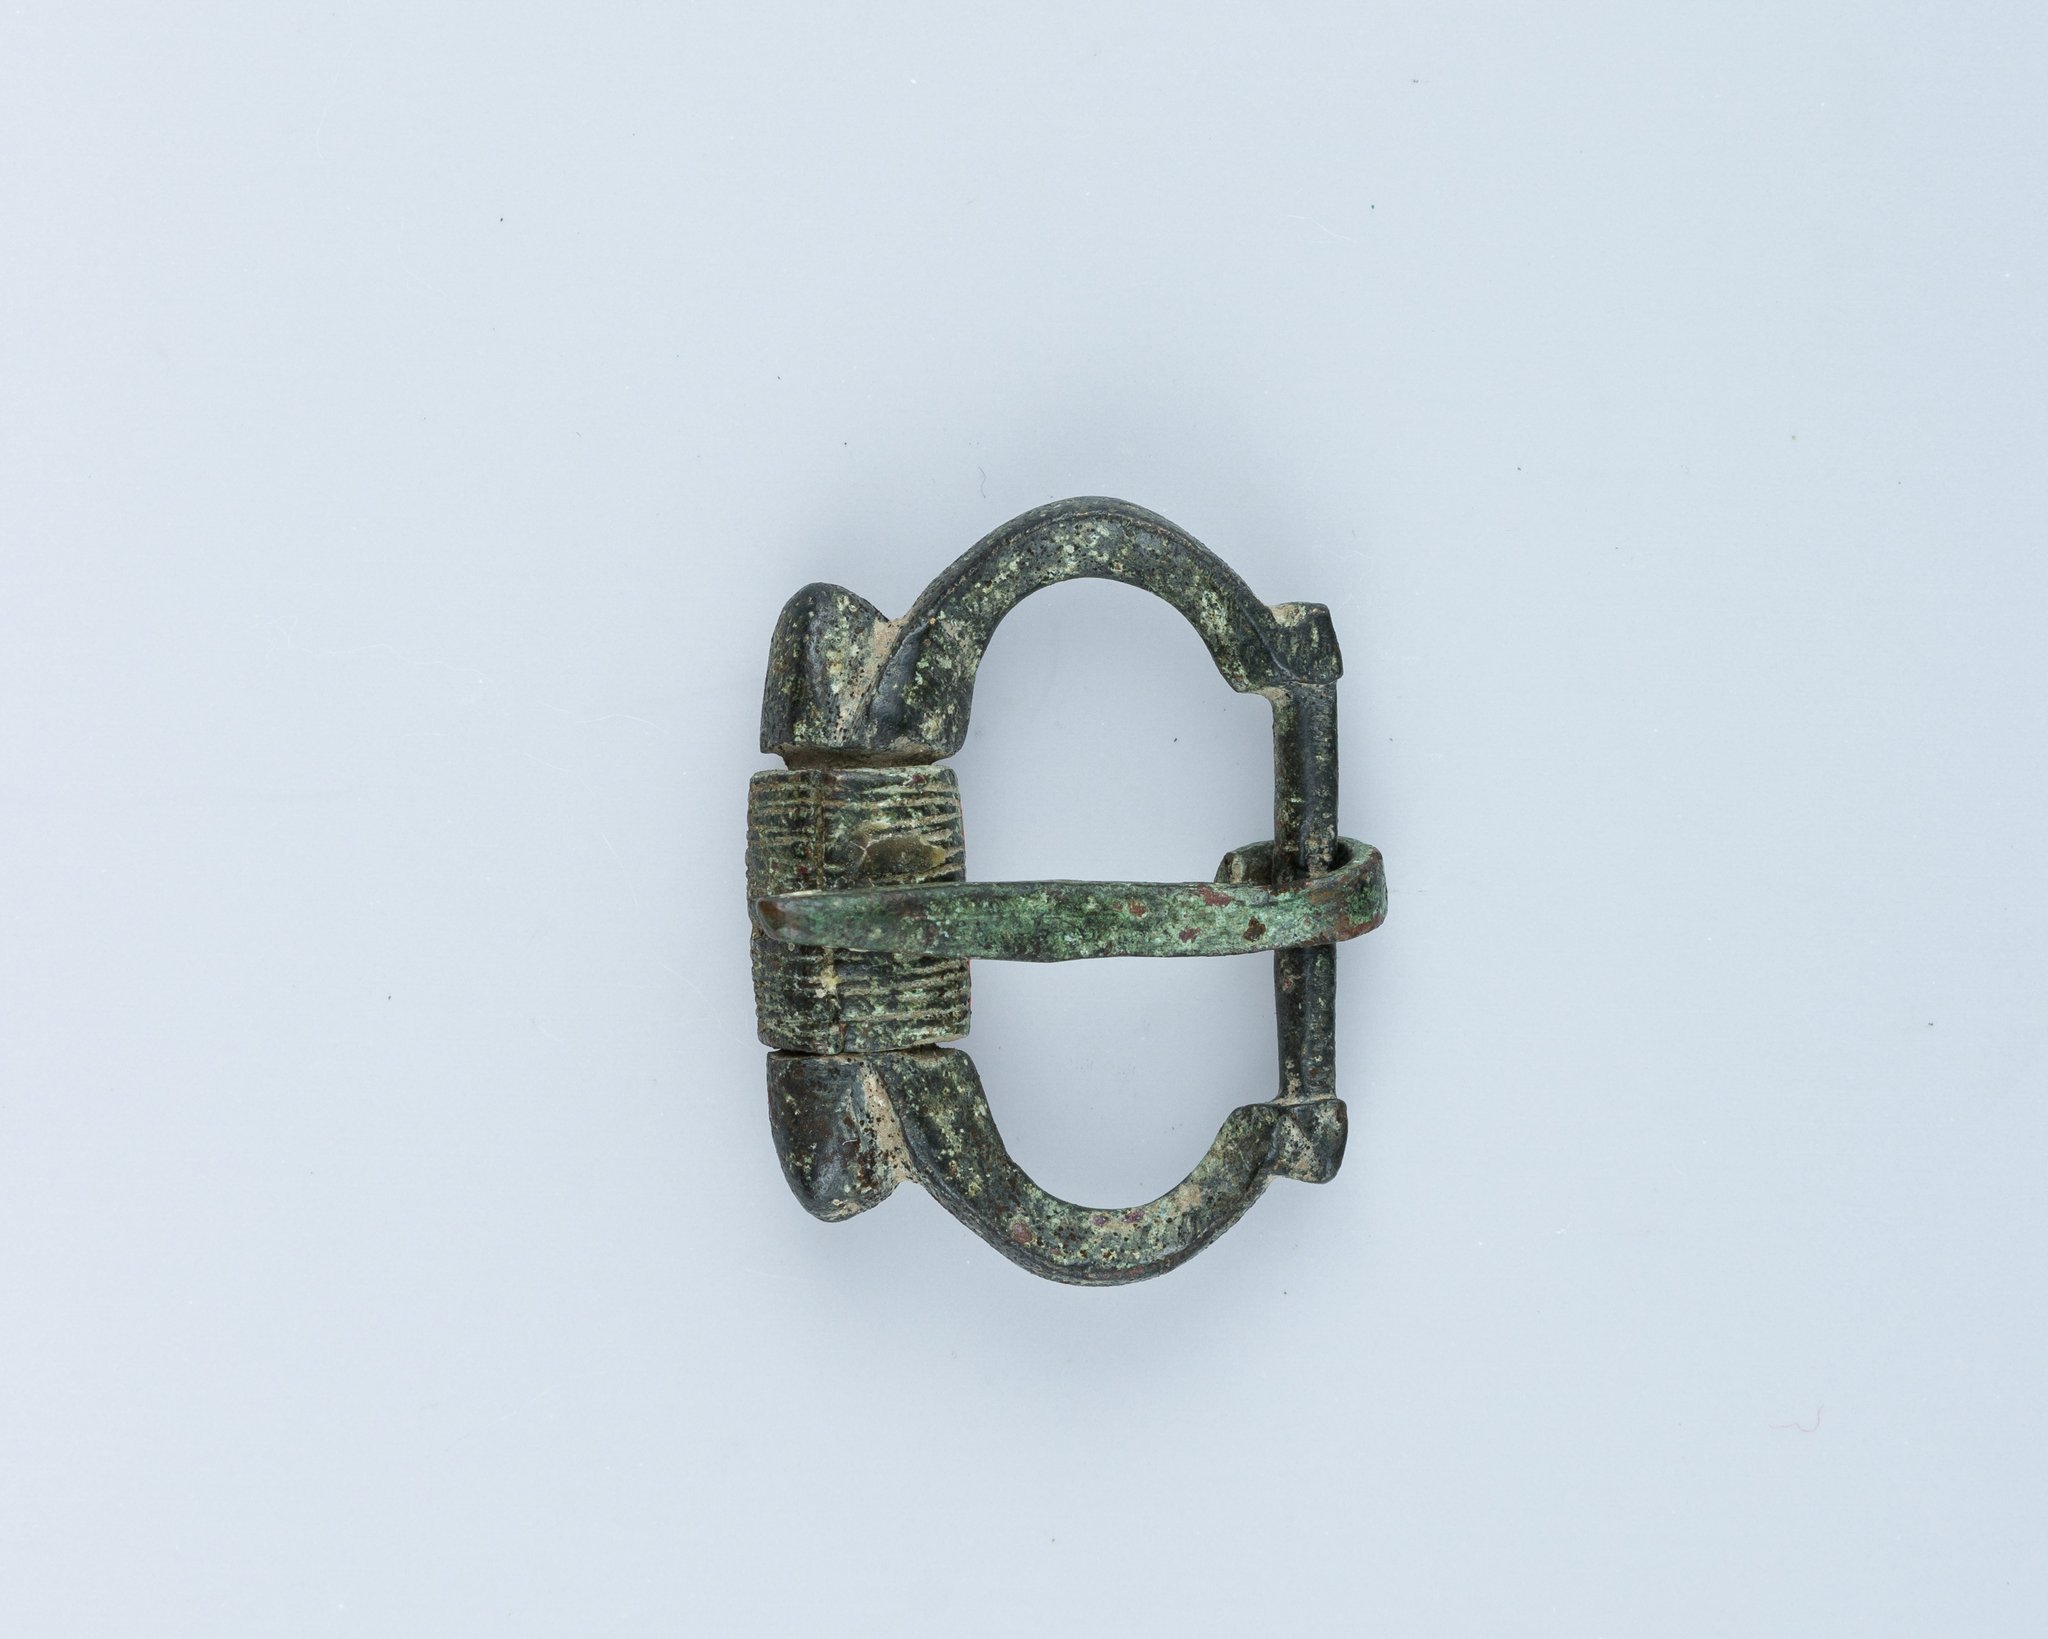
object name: buckle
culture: french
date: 1301-1400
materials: bronze, patina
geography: france